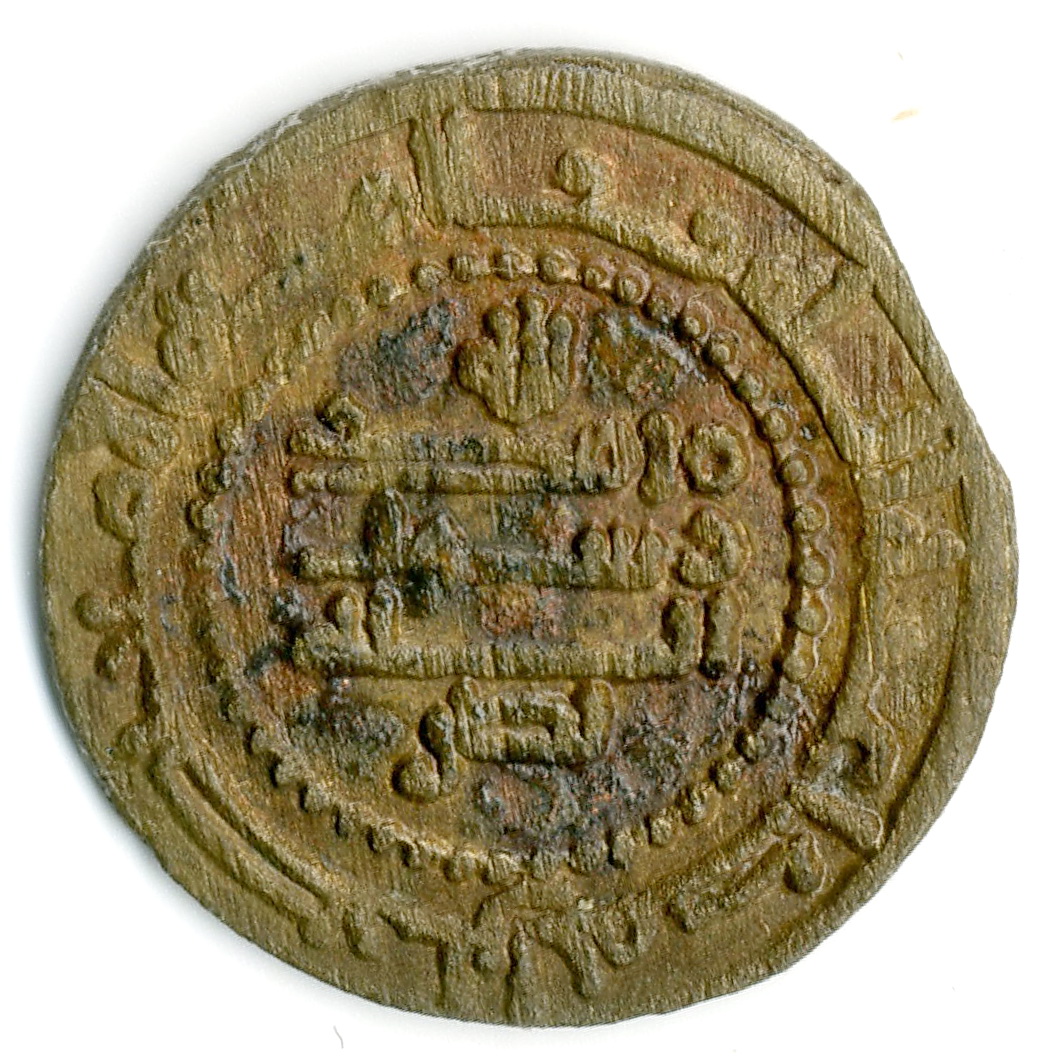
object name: coin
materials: copper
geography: uzbekistan